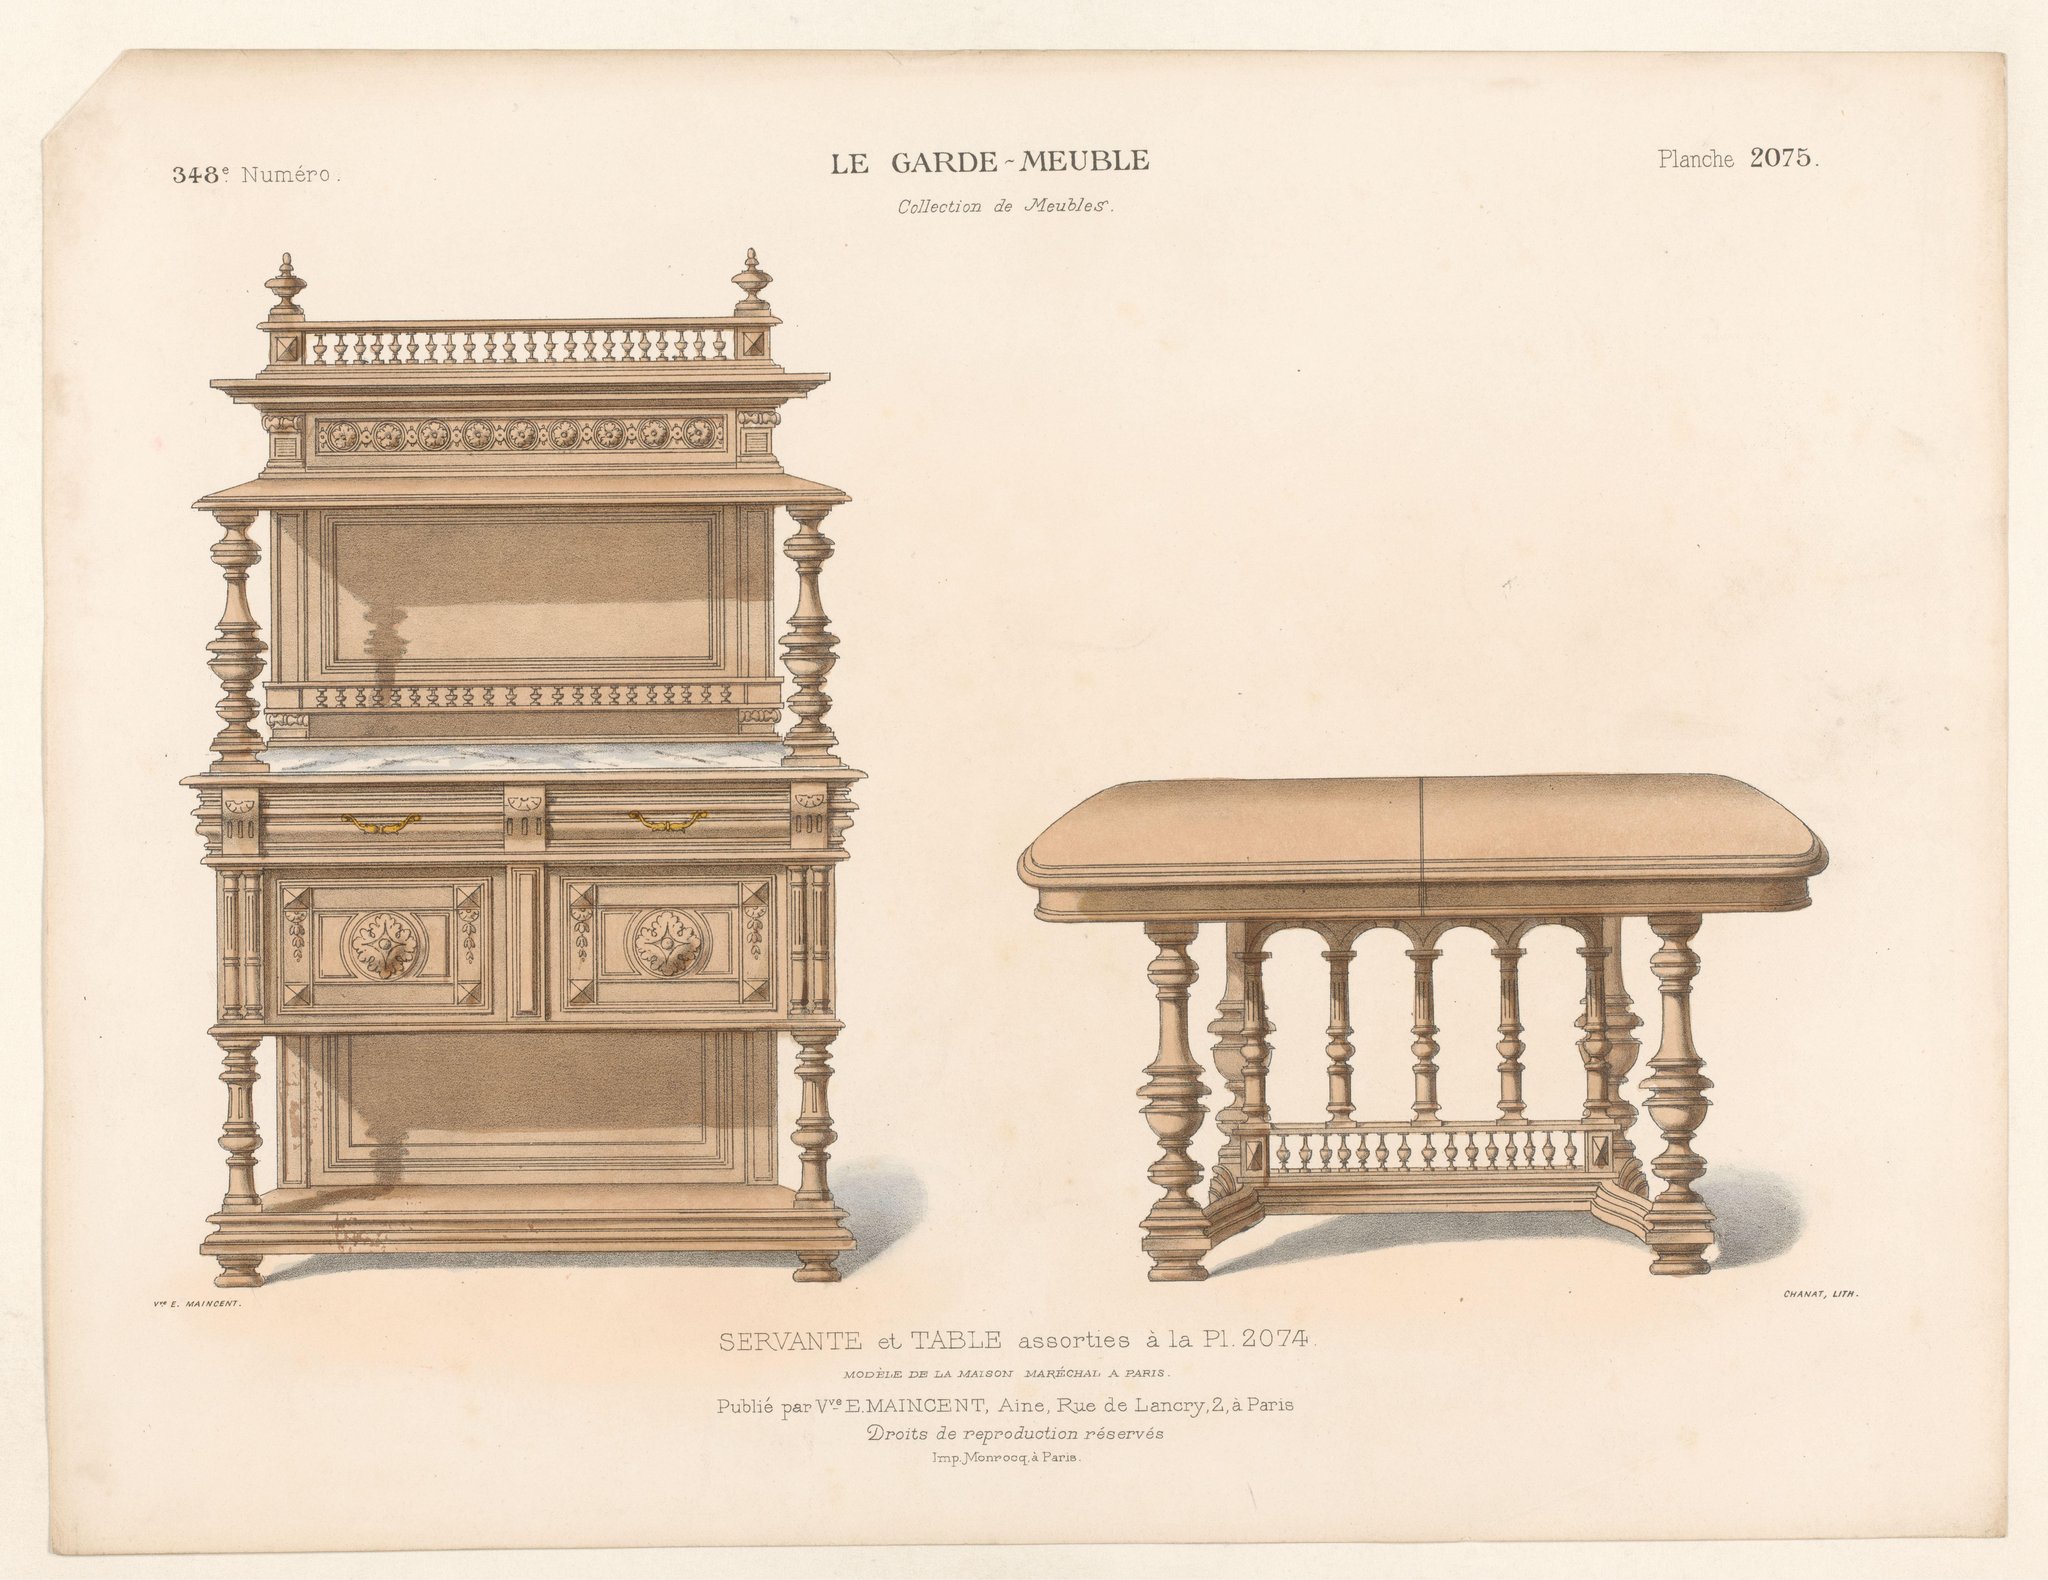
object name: print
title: Servante et table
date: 1895-1935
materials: paper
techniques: hand coloring, lithograph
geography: paris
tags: furniture for storage, table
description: Ieder Livraison in de serie Le Garde-Meuble bevat negen platen: drie 'sièges' (zitmeubels), drie 'meubles' (diverse meubels zoals tafels en kasten) en drie 'tentures' (gordijnen en draperieën).